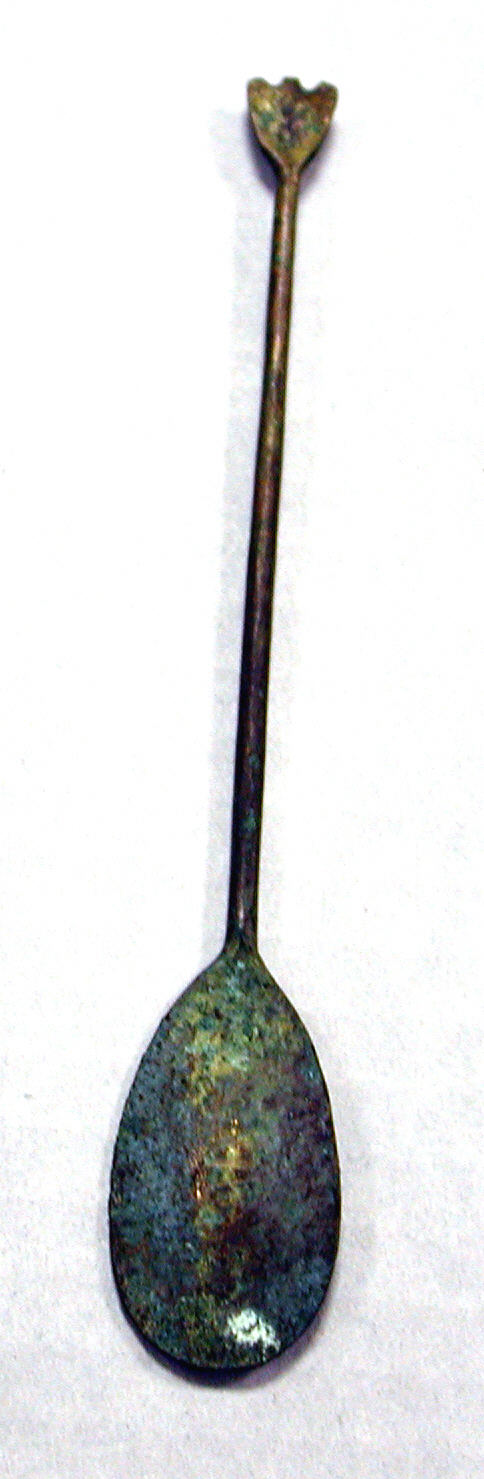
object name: spatula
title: Hammered Copper Spatula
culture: peruvian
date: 701-1566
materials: copper, silver gilt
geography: peru